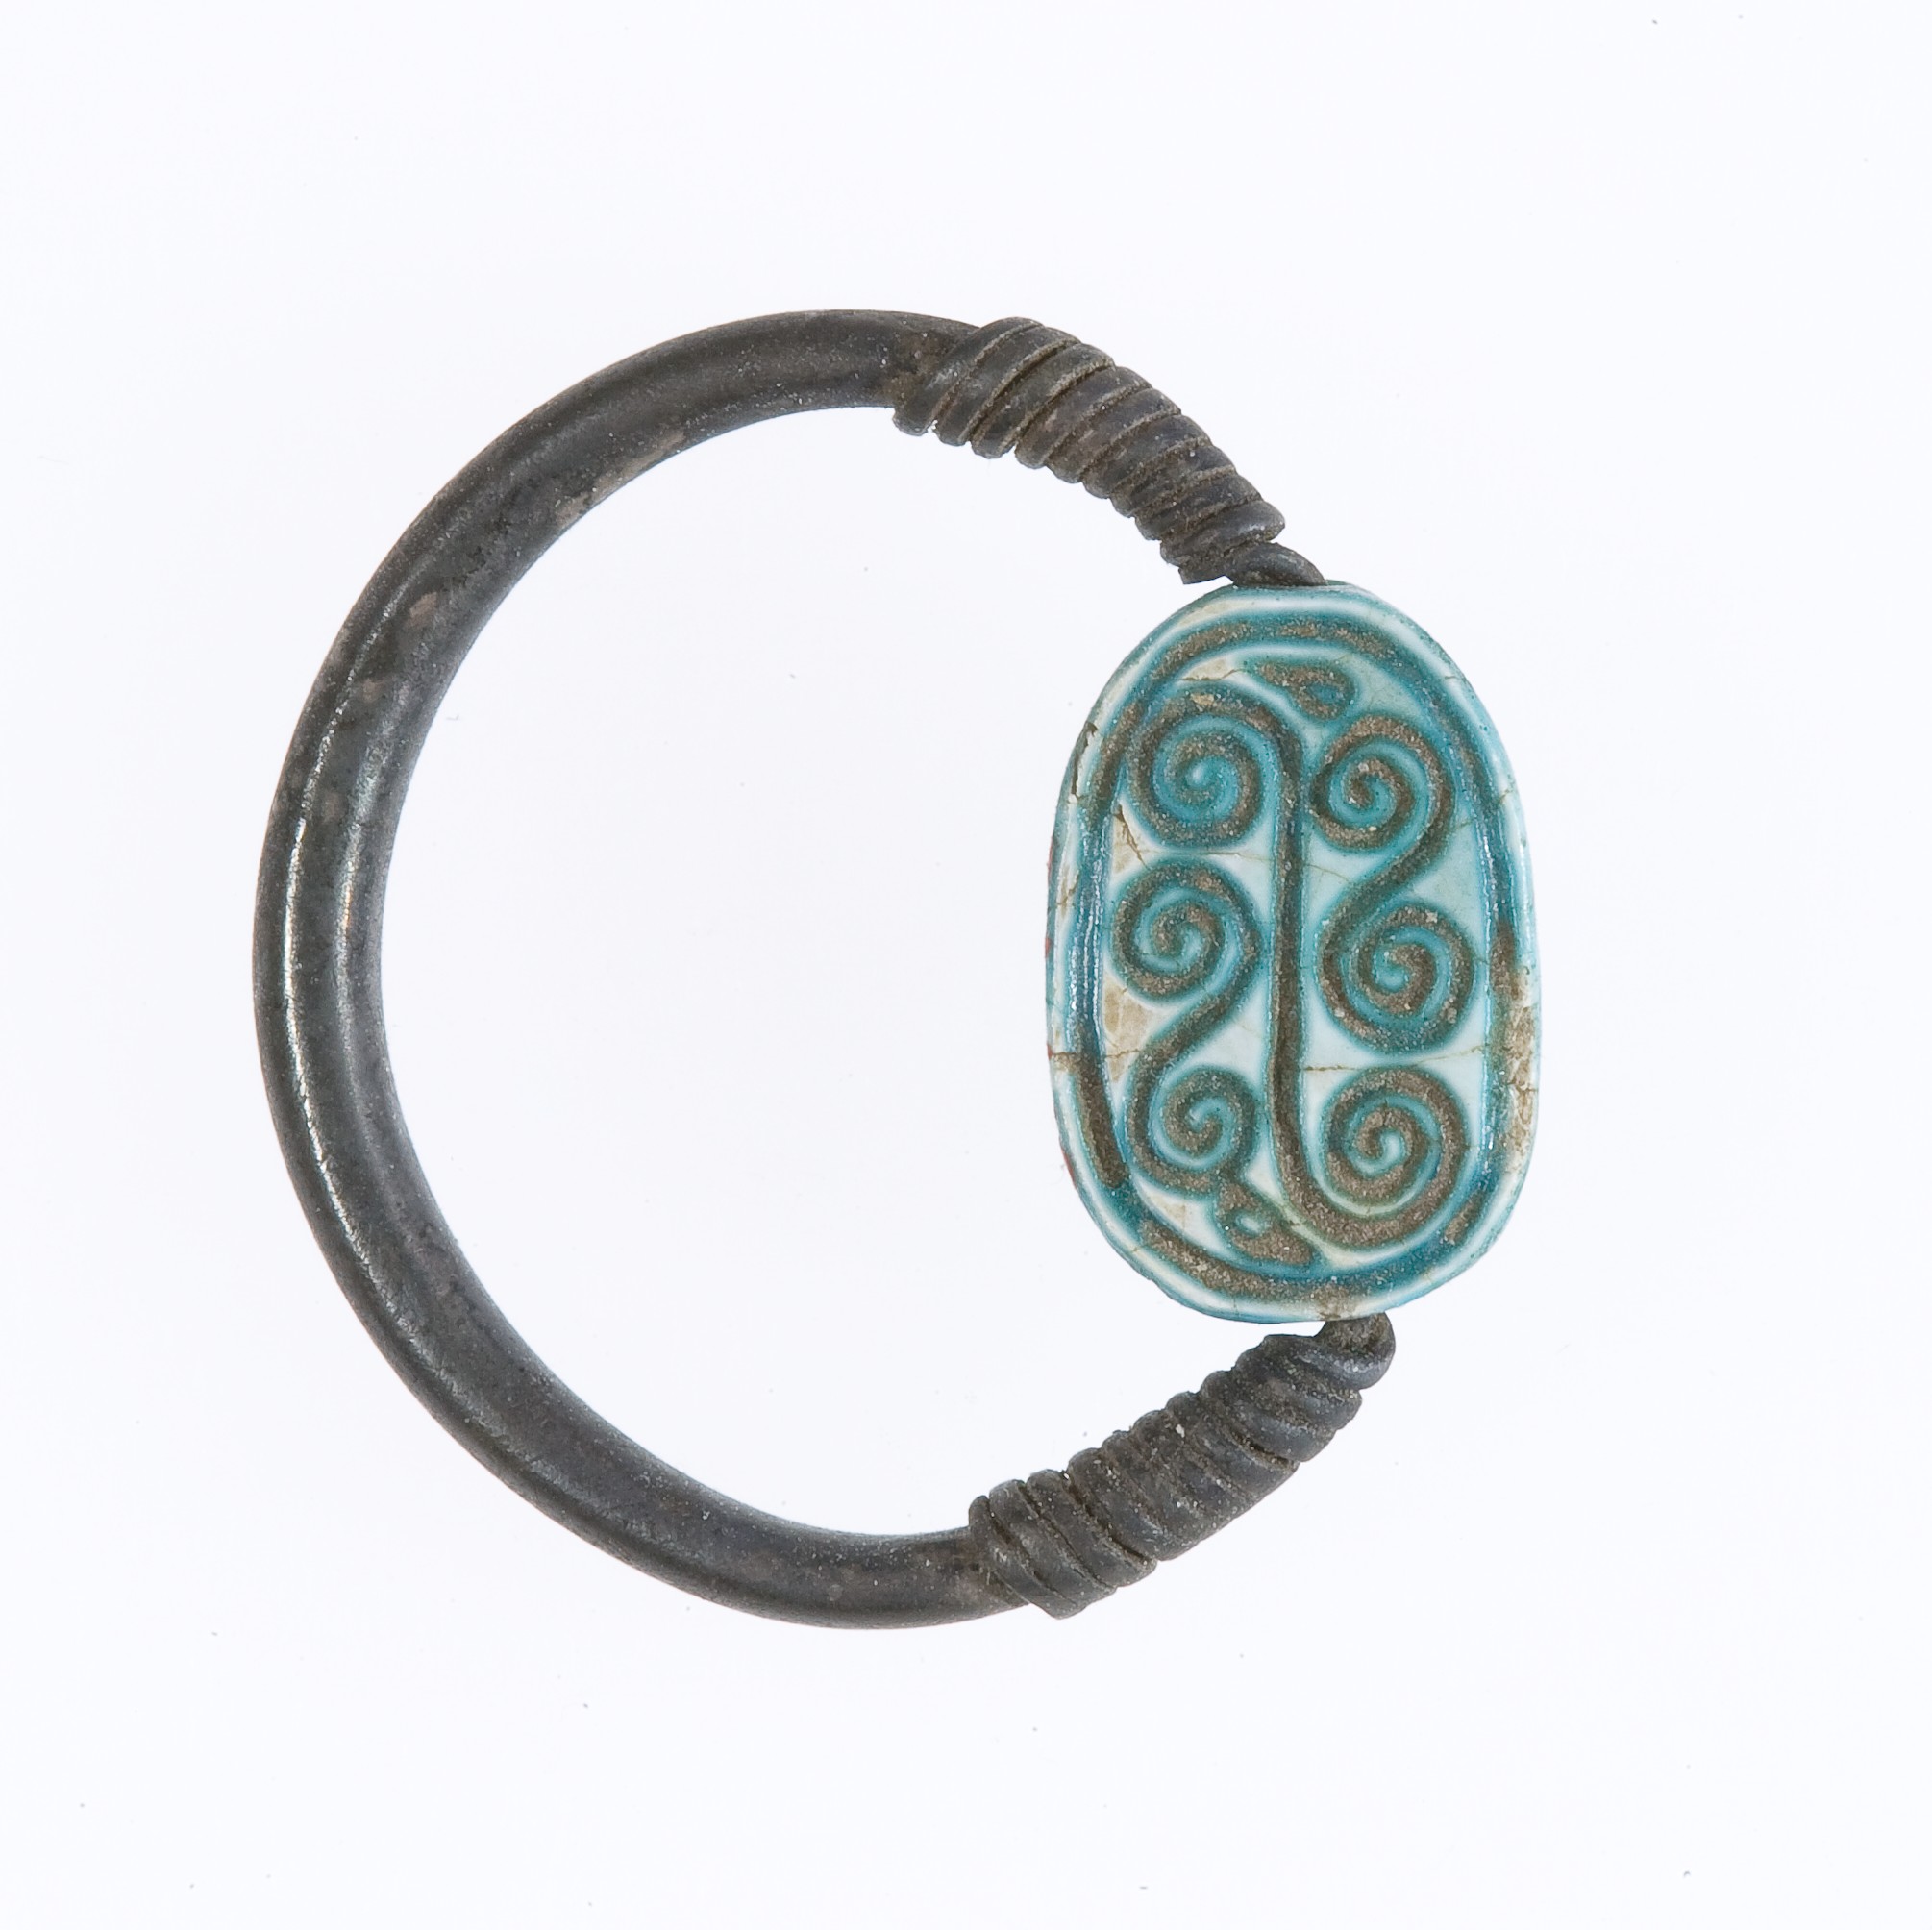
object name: ring with scarab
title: Scarab ring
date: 1991-1450 BCE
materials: silver, stone, metal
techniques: glazing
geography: egypt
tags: scarabs